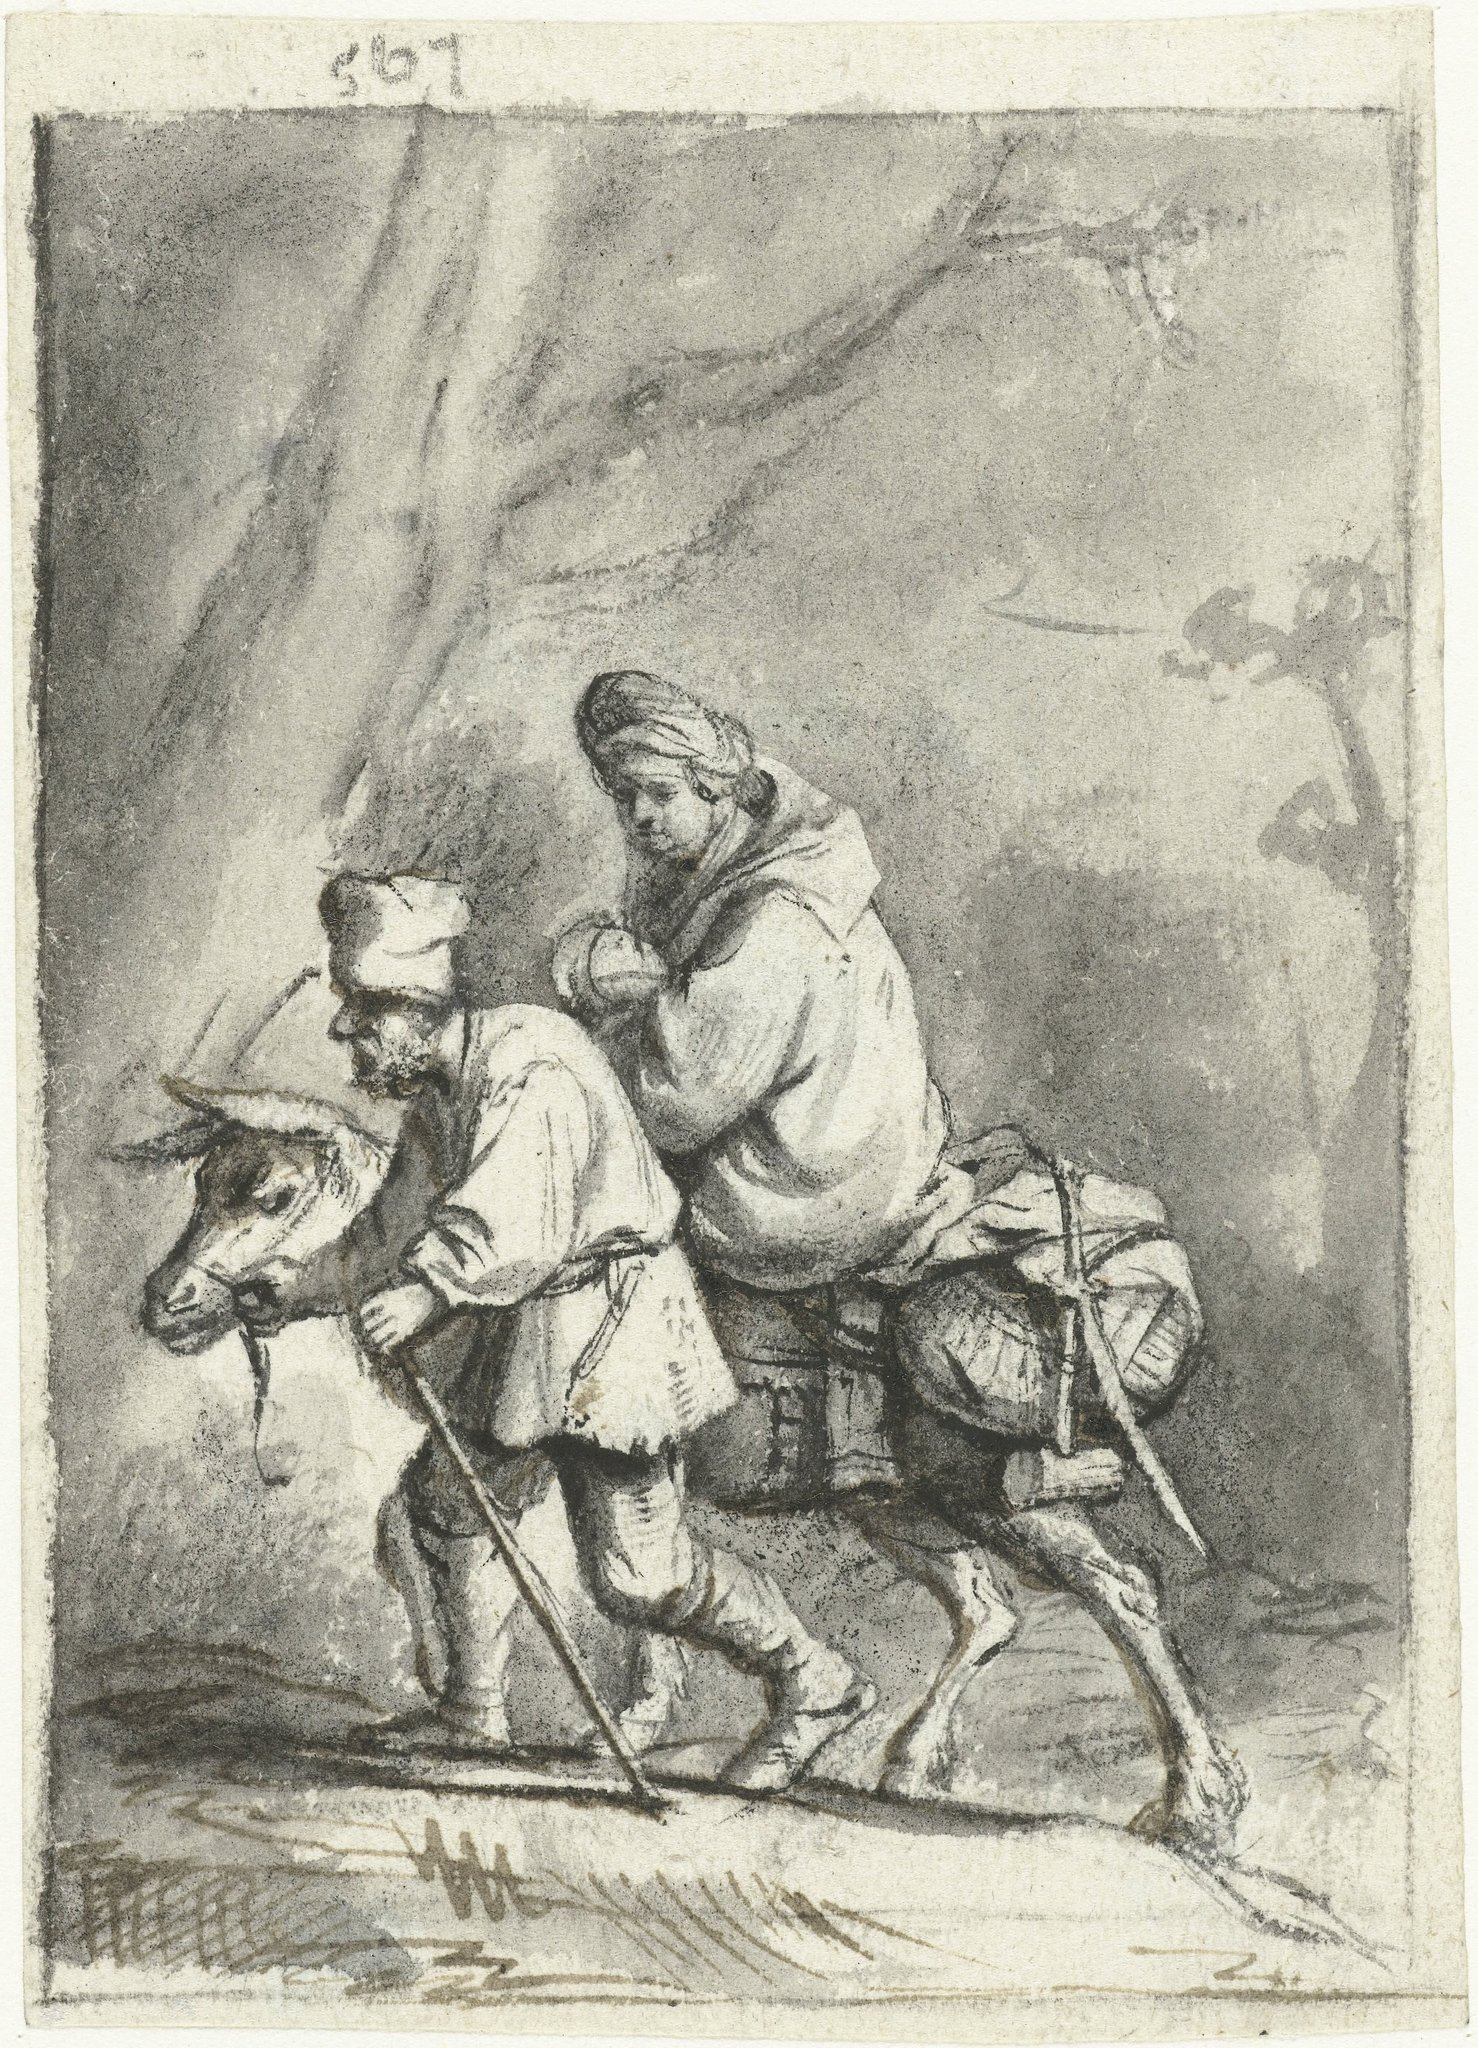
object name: drawing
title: De vlucht naar Egypte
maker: moses ter borch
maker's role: draughtsman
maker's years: 1645-1667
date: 1659-1660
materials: chalk, ink, paper, watercolor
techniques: brush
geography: zwolle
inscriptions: annotation: ‘Bartsch 52’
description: Kopie naar ets van Rembrandt (De vlucht naar Egypte: kleine etsplaat), B. 52 (1633).